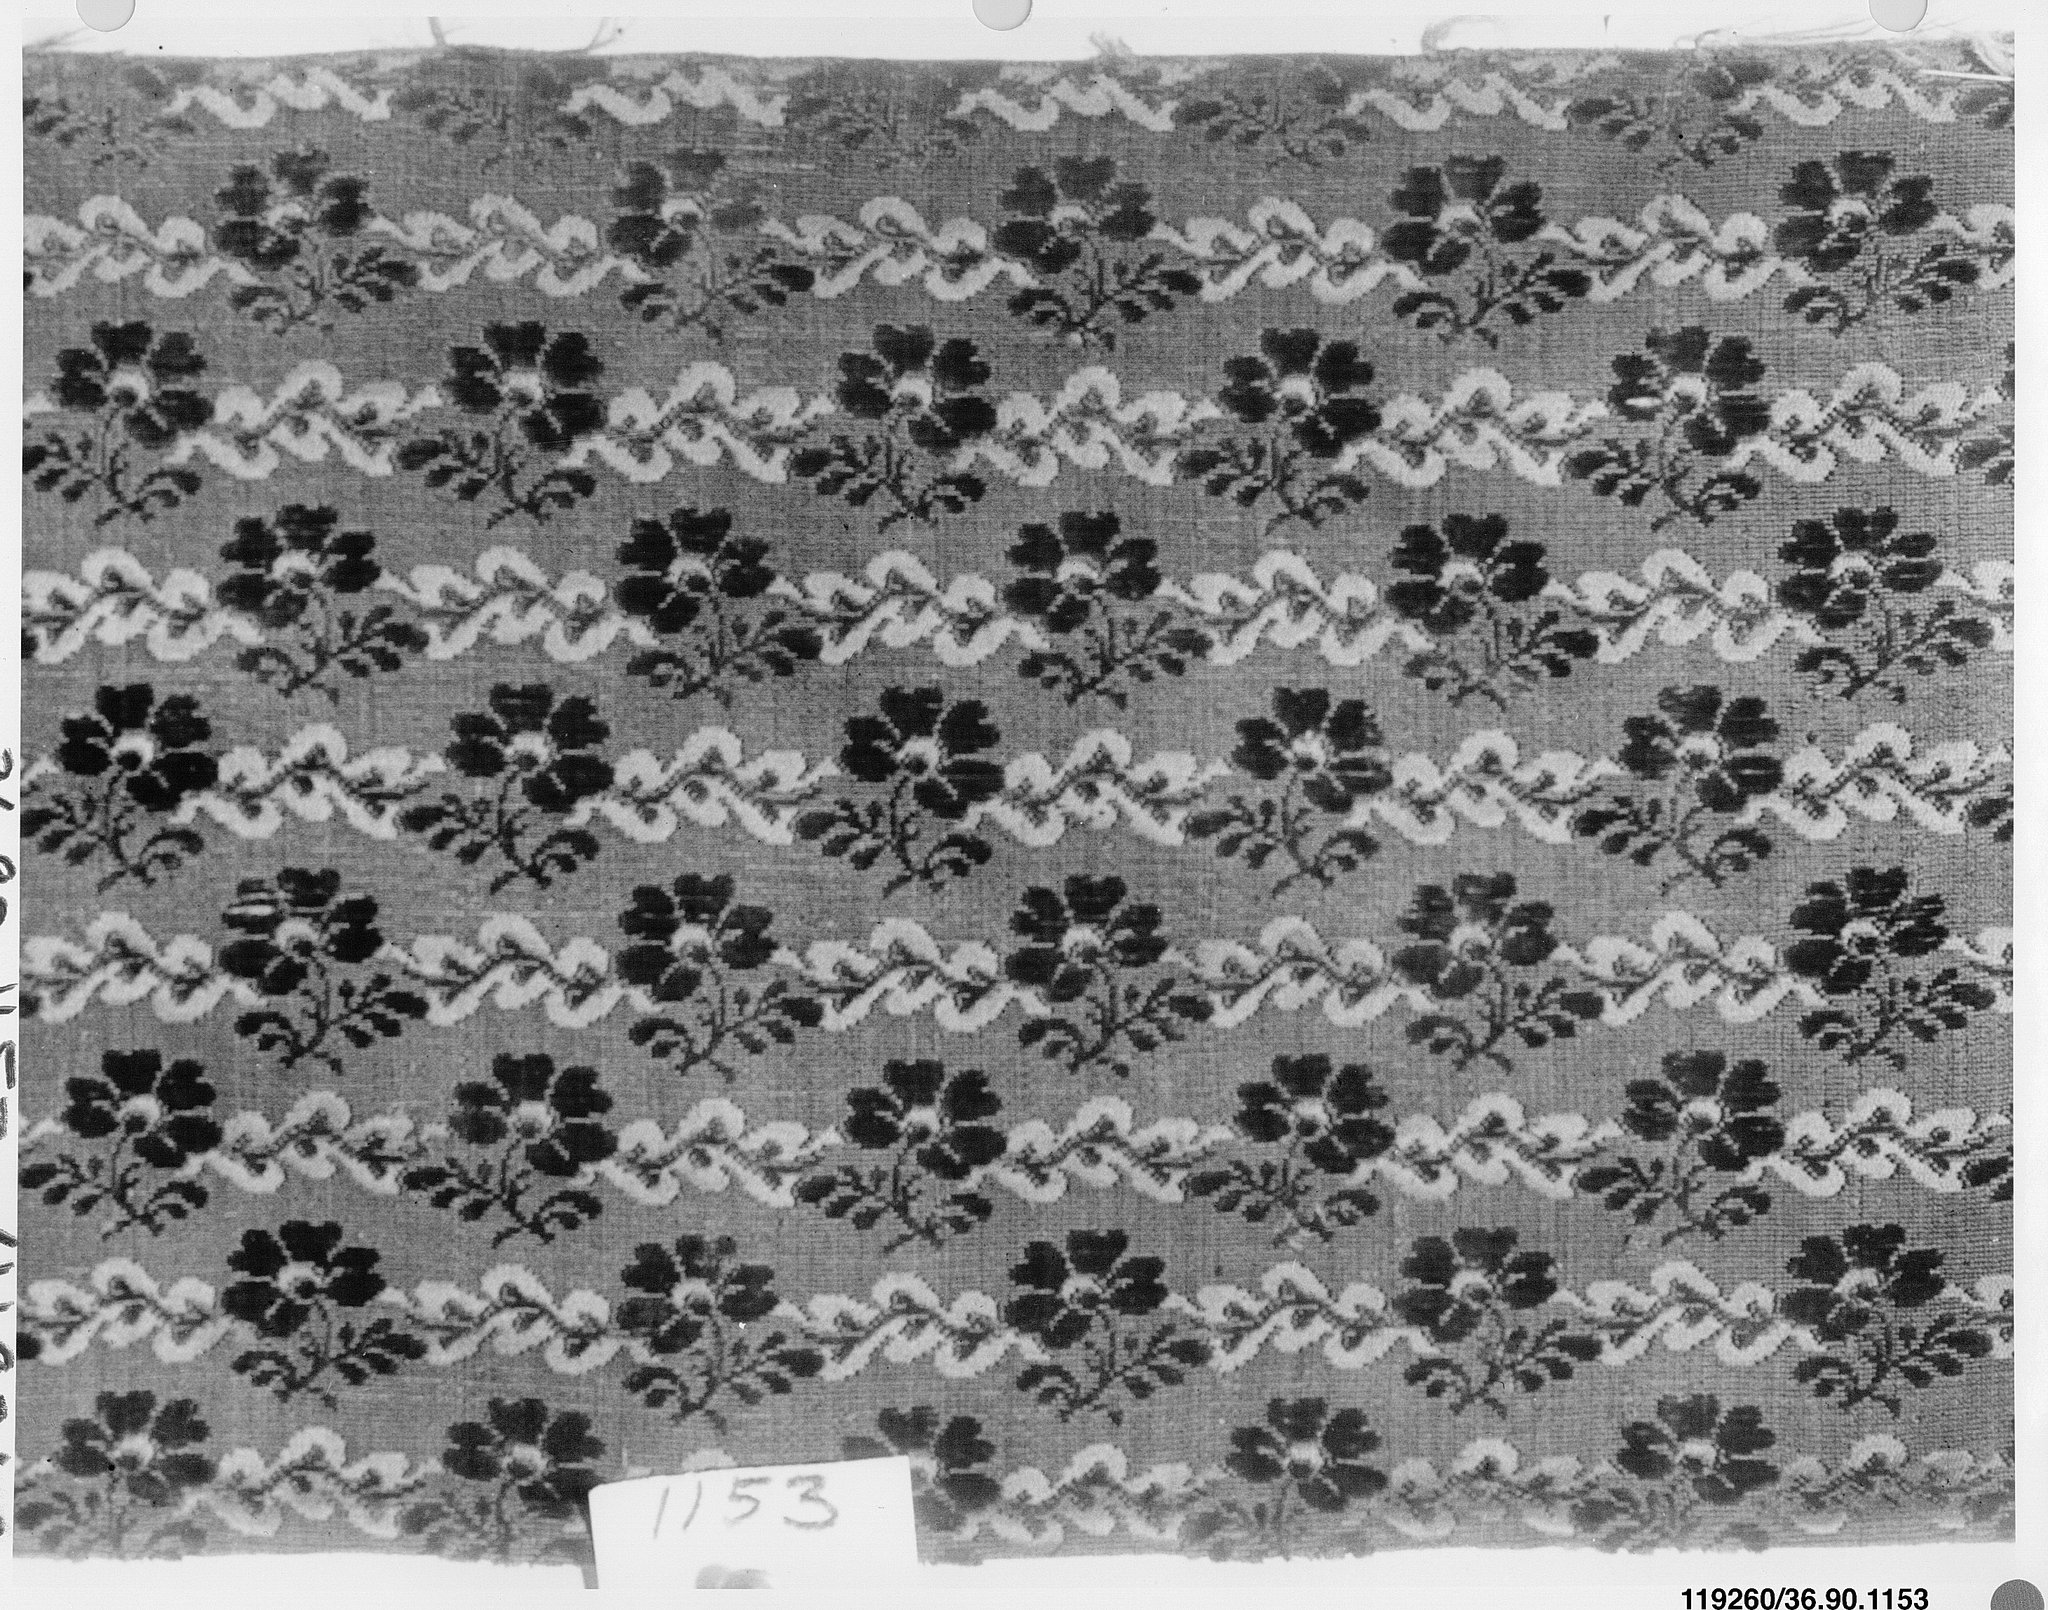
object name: piece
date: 1701-1800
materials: silk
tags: flowers,leaves